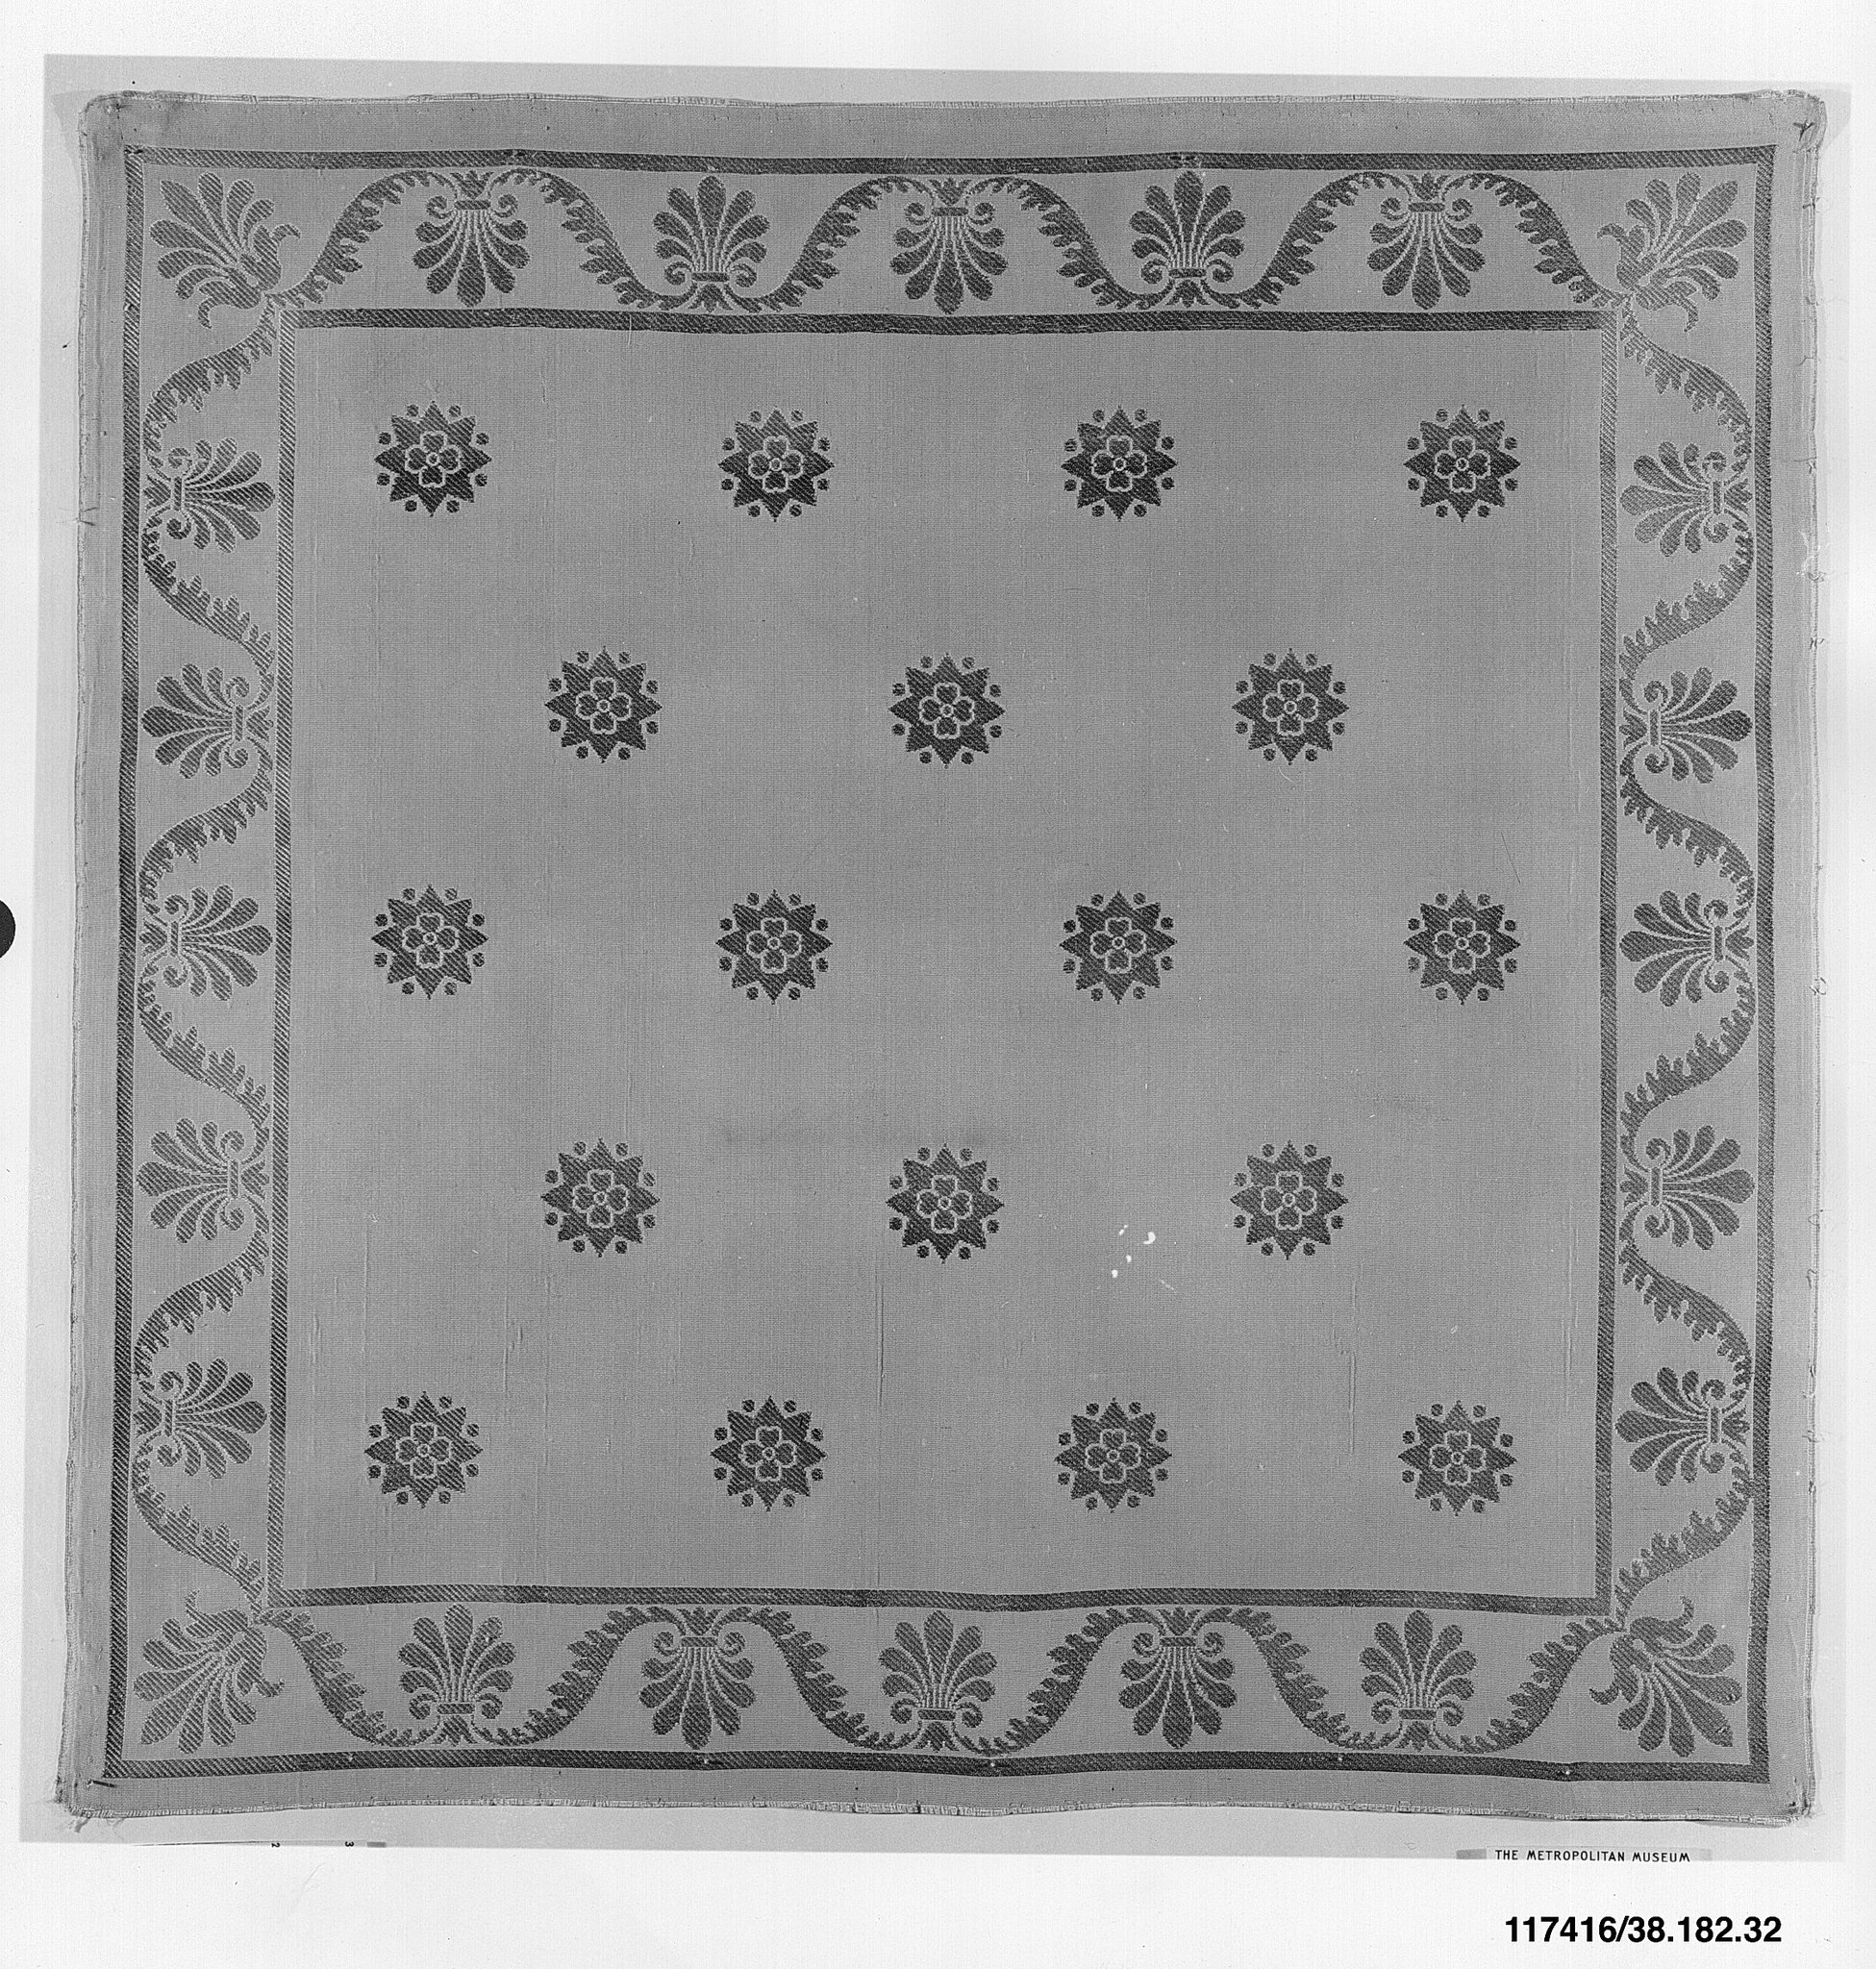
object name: panel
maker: séguin et cie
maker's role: manufactory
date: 1811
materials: metal thread, silk